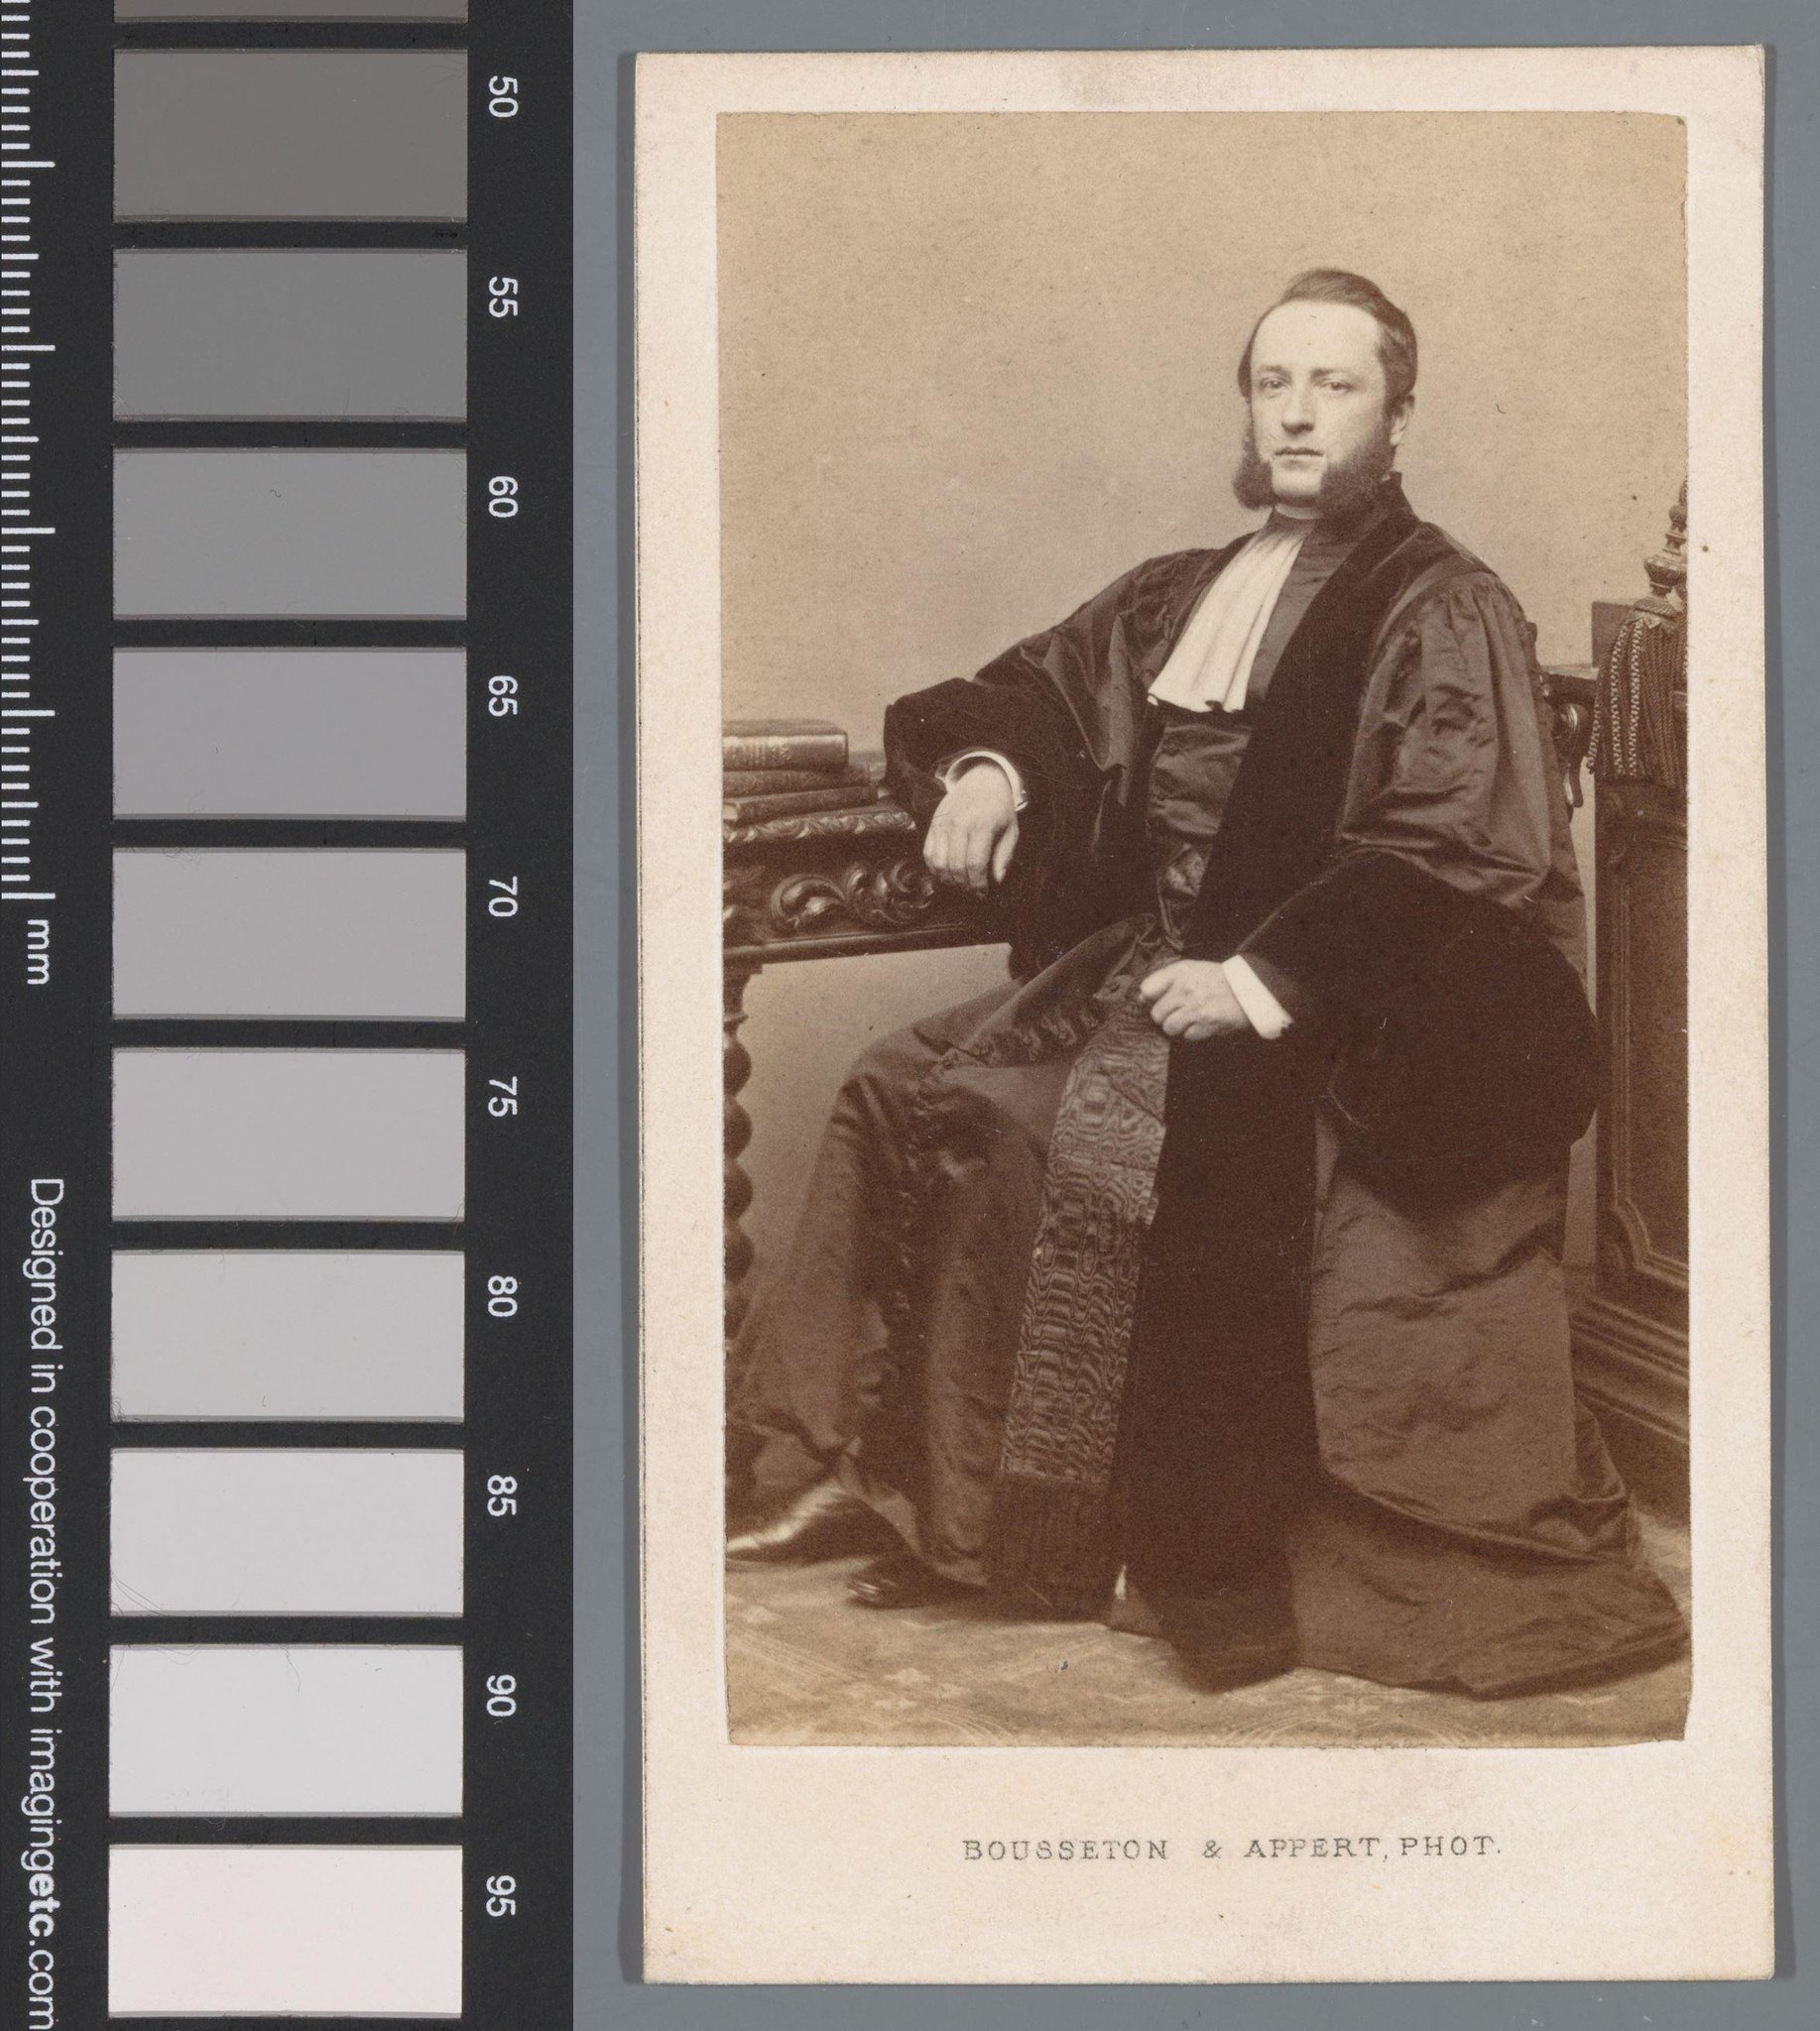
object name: photograph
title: Portret van een onbekende rechtsgeleerde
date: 1860-1868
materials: cardboard, paper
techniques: albumen print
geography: paris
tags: lawyer, attorney at law, anonymous historical person portrayed, paris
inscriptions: inscription: ‘Photographe de la magistrature/ médailles d'argent/ anc. maison E. Défonds/ Bousseton & Appert/ Peintres photographes/ de S.M. la Reine d'Espagne/ de la Maison de l'Empereur/ de salle grand Duc Constantin./ 21 Rue Louis le Grand,/ au 1er Étage/ Paris/ Les Clichés étant conservés indéfiniment,/ on peut toujours se procurer de nouvelles/ épreuves de Cartes & Portraits sans reposer.’, inscription: ‘Bousseton & Appert, phot.’